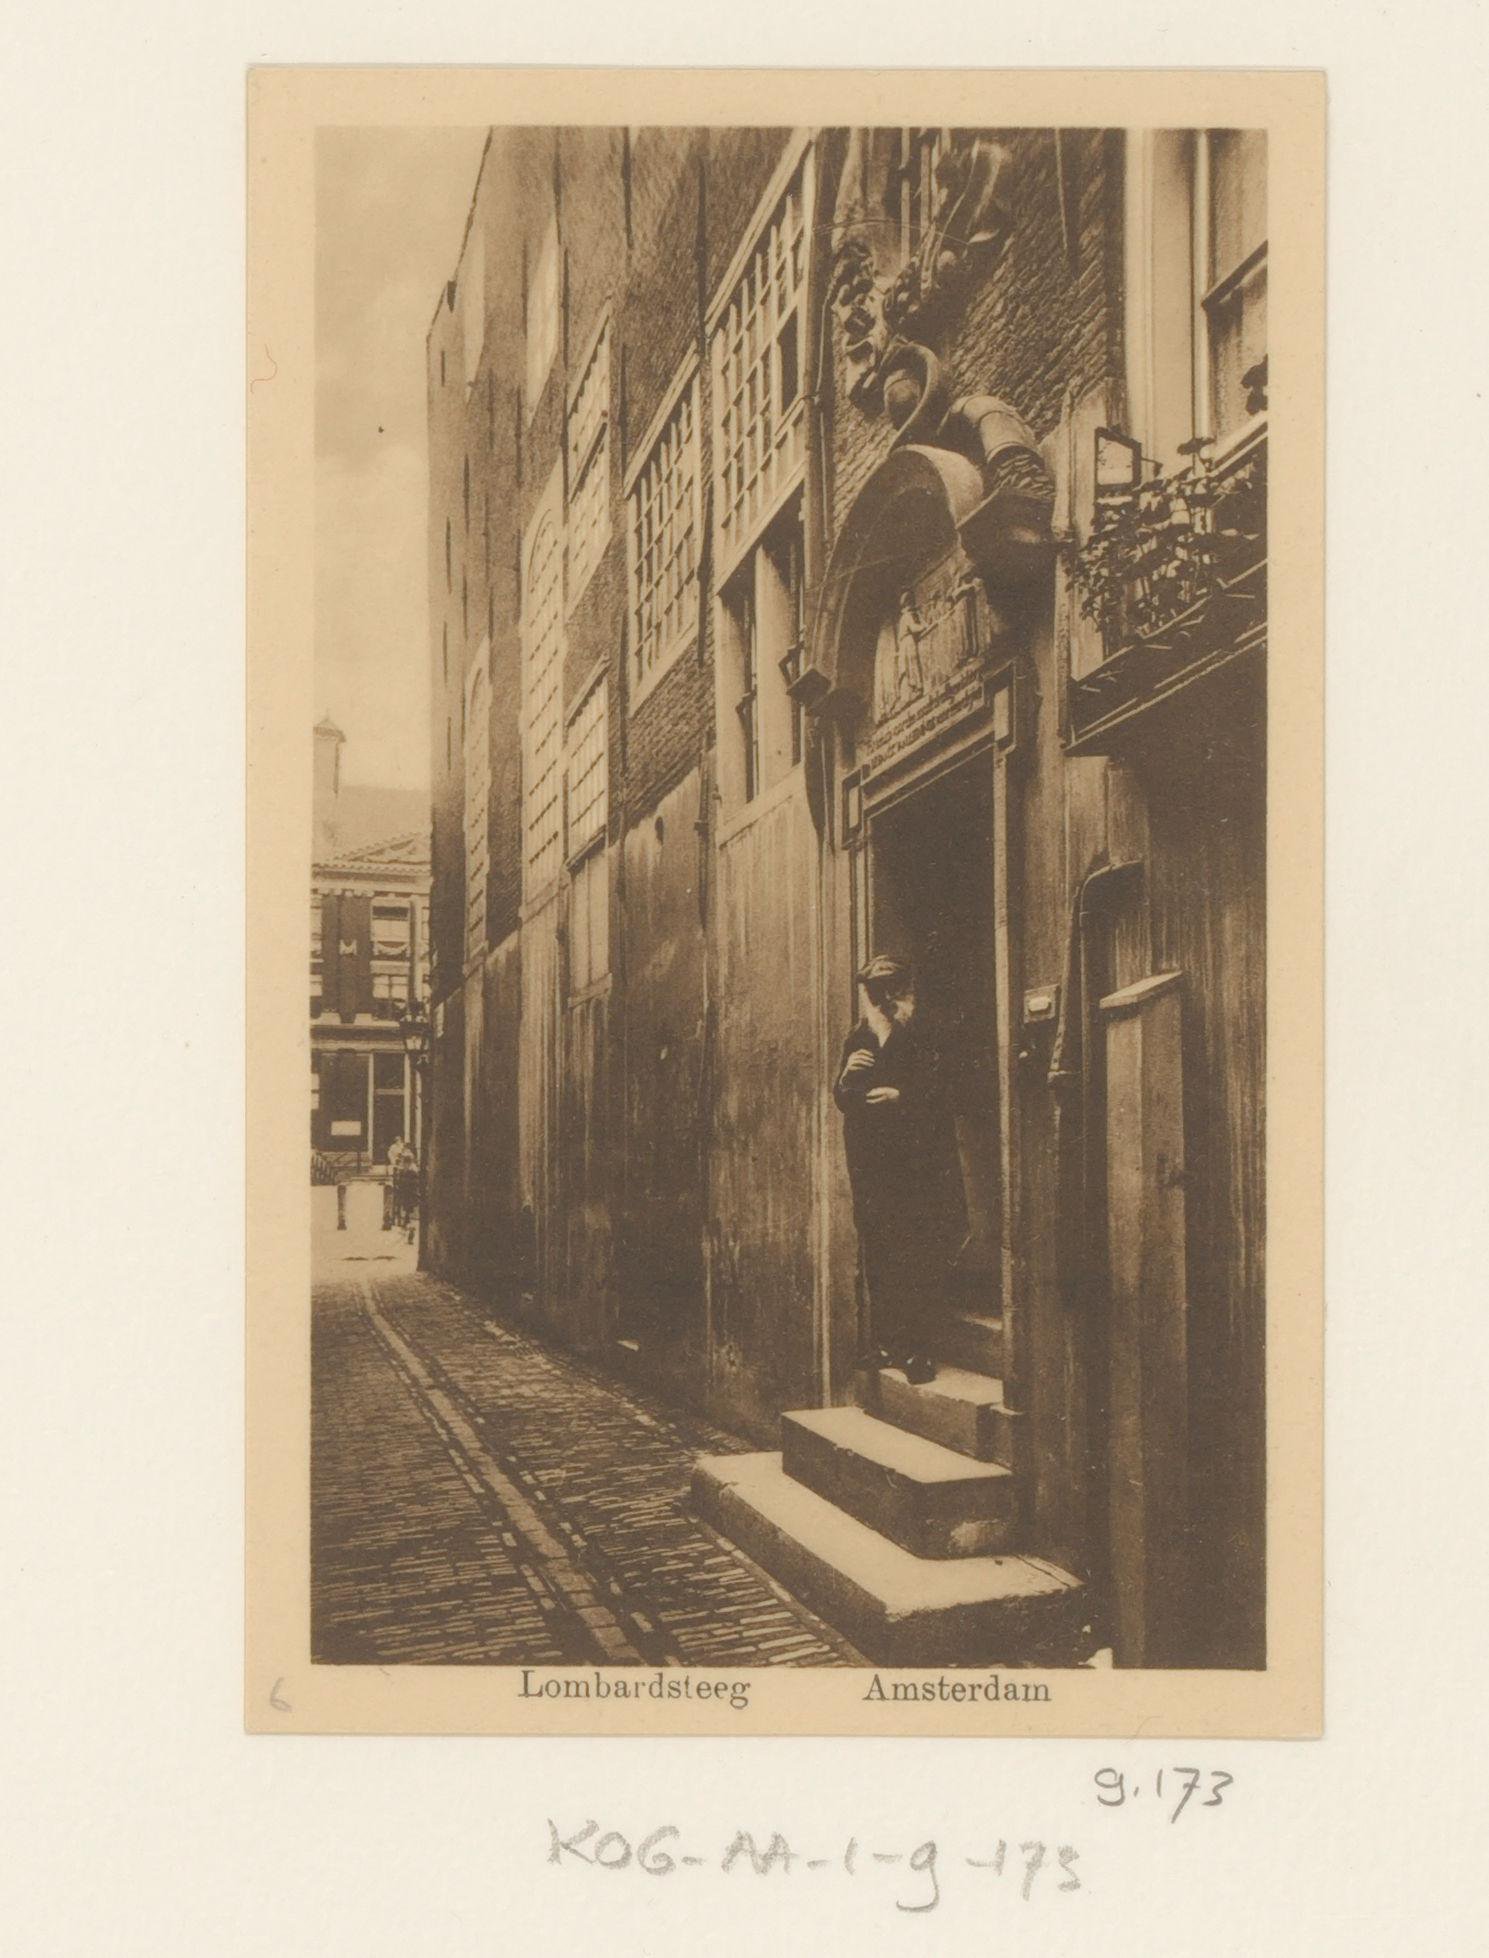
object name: ansichtkaart, prentbriefkaart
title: Gezicht op de Lombardsteeg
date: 1905-1930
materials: cardboard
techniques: photograph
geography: amsterdam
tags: city-view in general; 'veduta', lane, alley, façade (of house or building)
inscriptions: collector's mark: ‘9.173’ Lugt 1641b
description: Onderwerpsrubriek binnen de Atlas Amsterdam: 2e Laurierdwarsstraat (Vuile Weespad), Leidschegracht, Leidschekade, Leidscheplein, Leidschestraat, v. Lennepkade, Lijnbaansgracht, Lauriergracht, Leliedwarsstraat, Leliegracht, Lindengracht, Lombardsteeg, Looiersgracht, Looiersstraat (Nieuwe), Leidekkerssteeg.